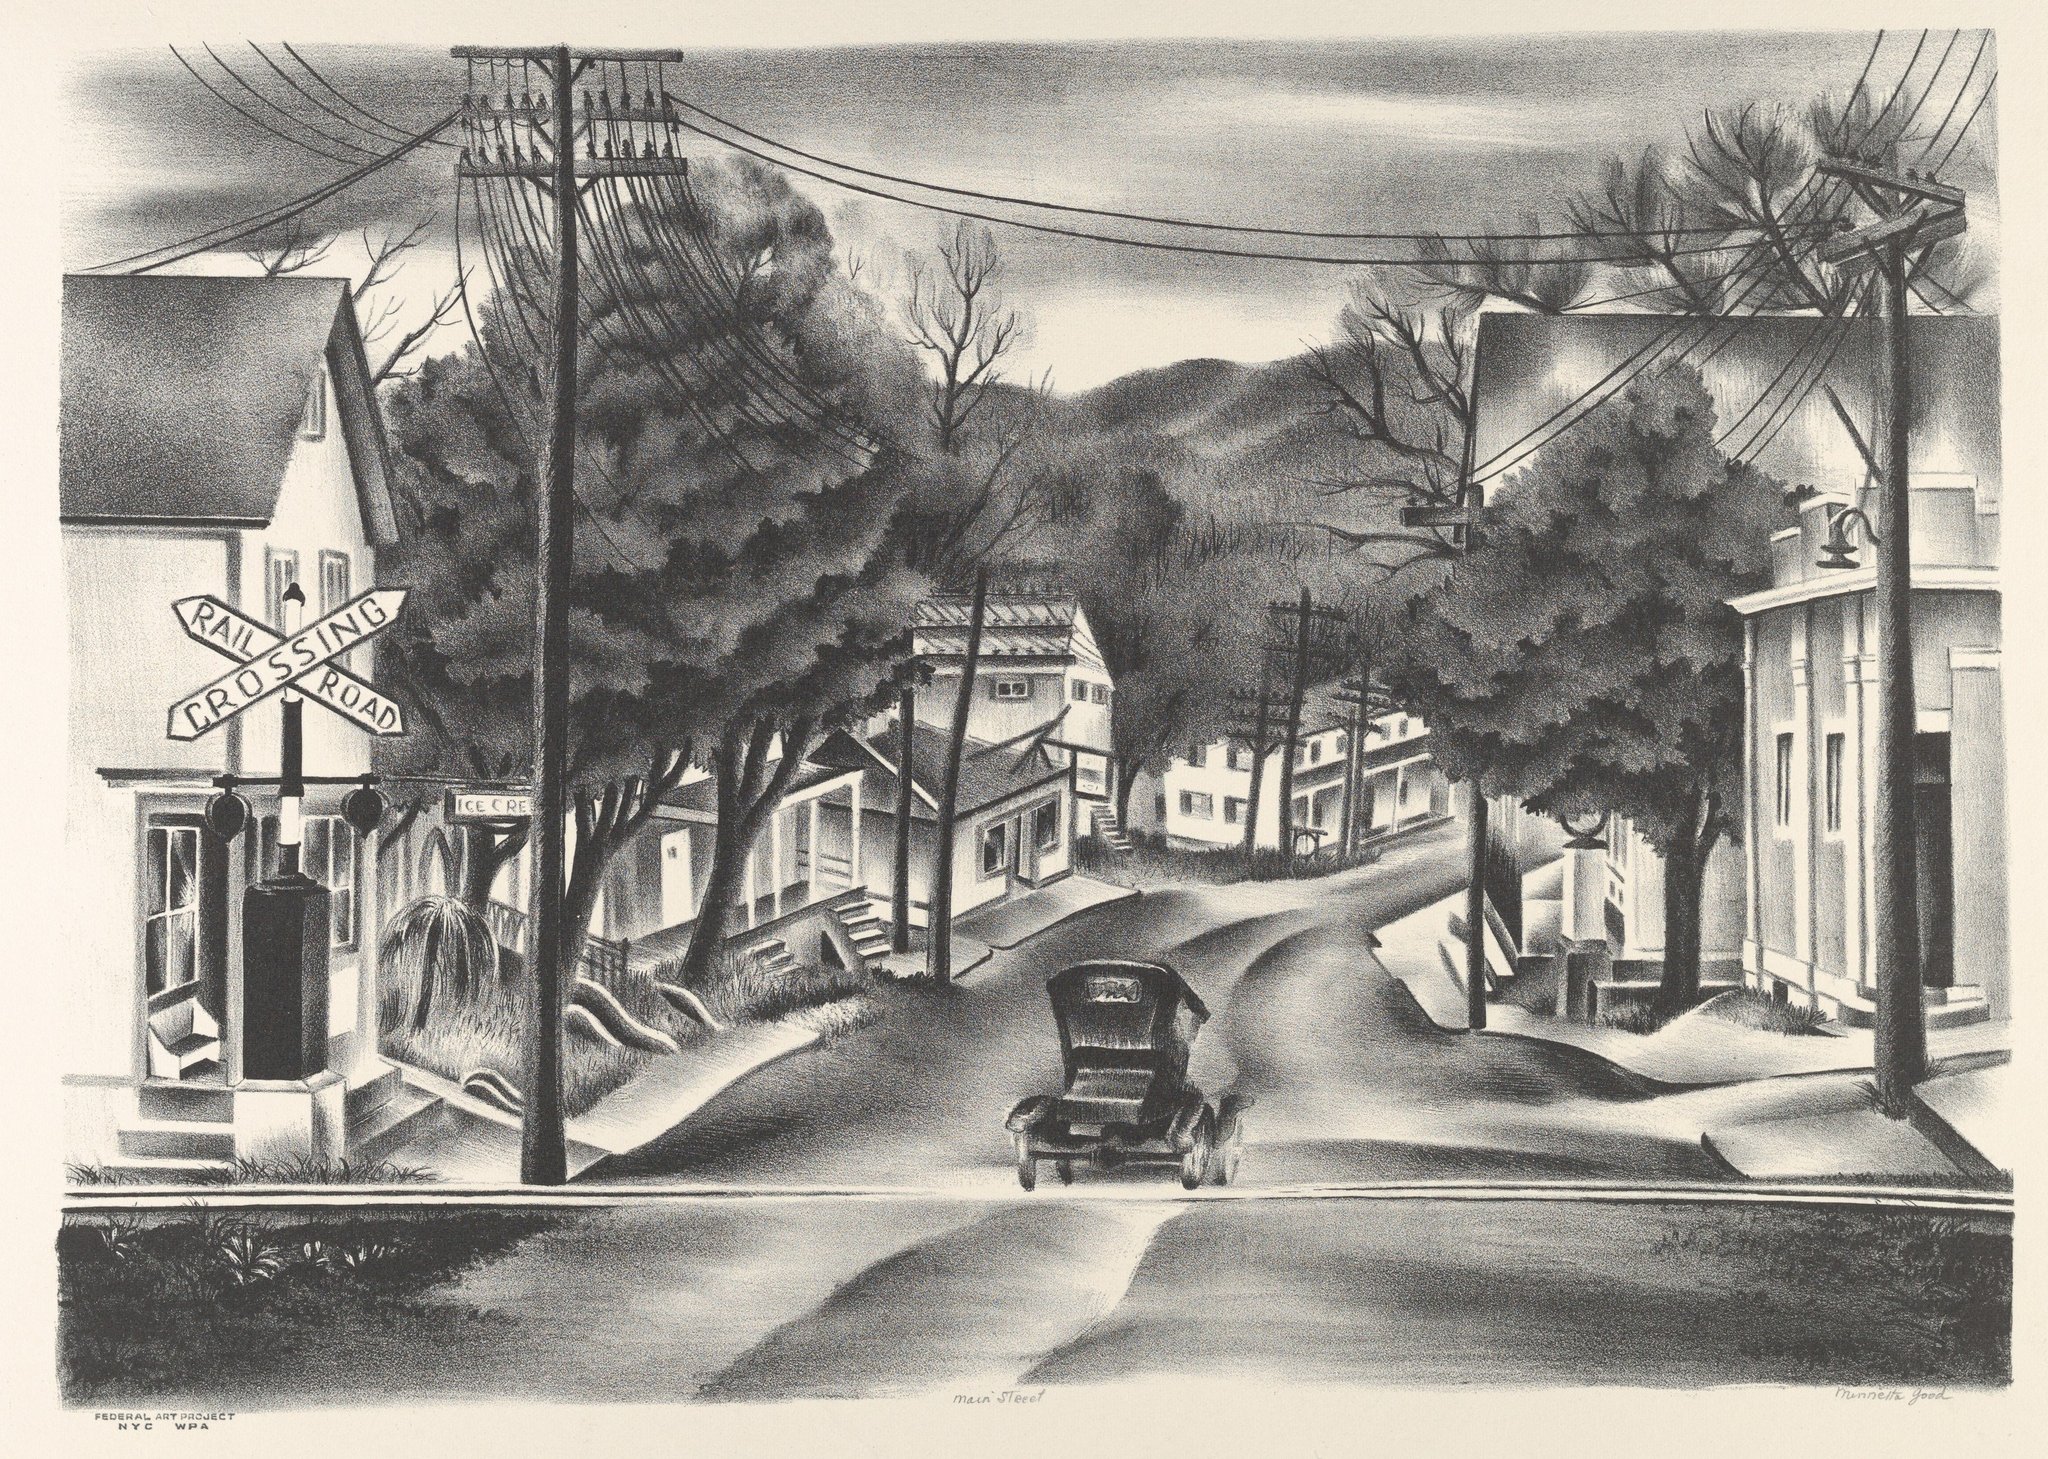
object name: print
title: Main Street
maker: minnetta good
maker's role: artist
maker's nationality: american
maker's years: 1895-1946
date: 1939-1940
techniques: lithograph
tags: houses,streets,cars